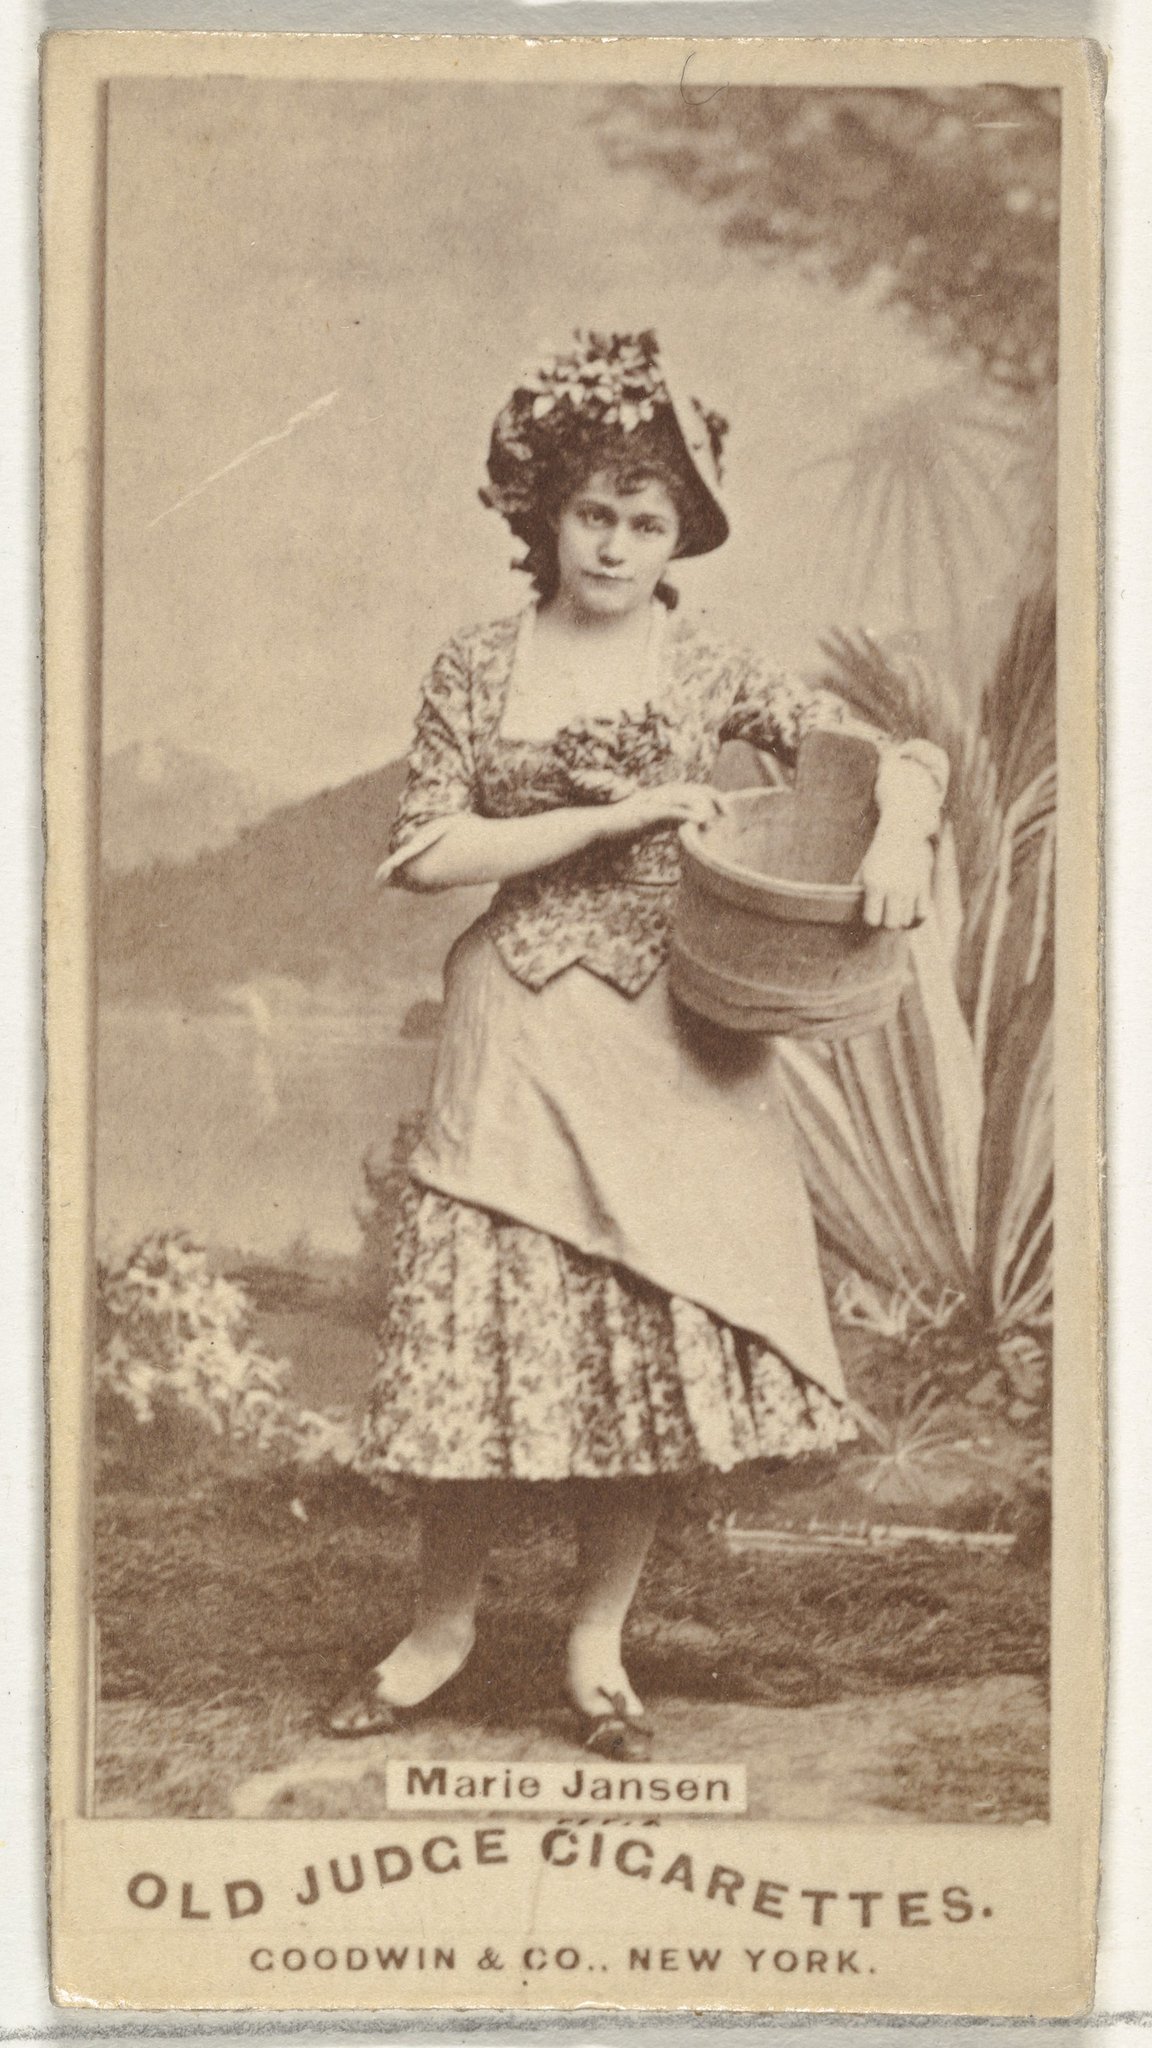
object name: photograph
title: Marie Jansen, from the Actors and Actresses series (N171) for Old Judge Cigarettes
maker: goodwin & company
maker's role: publisher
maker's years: 1850-1950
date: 1886-1890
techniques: albumen silver print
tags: portraits,women,actresses